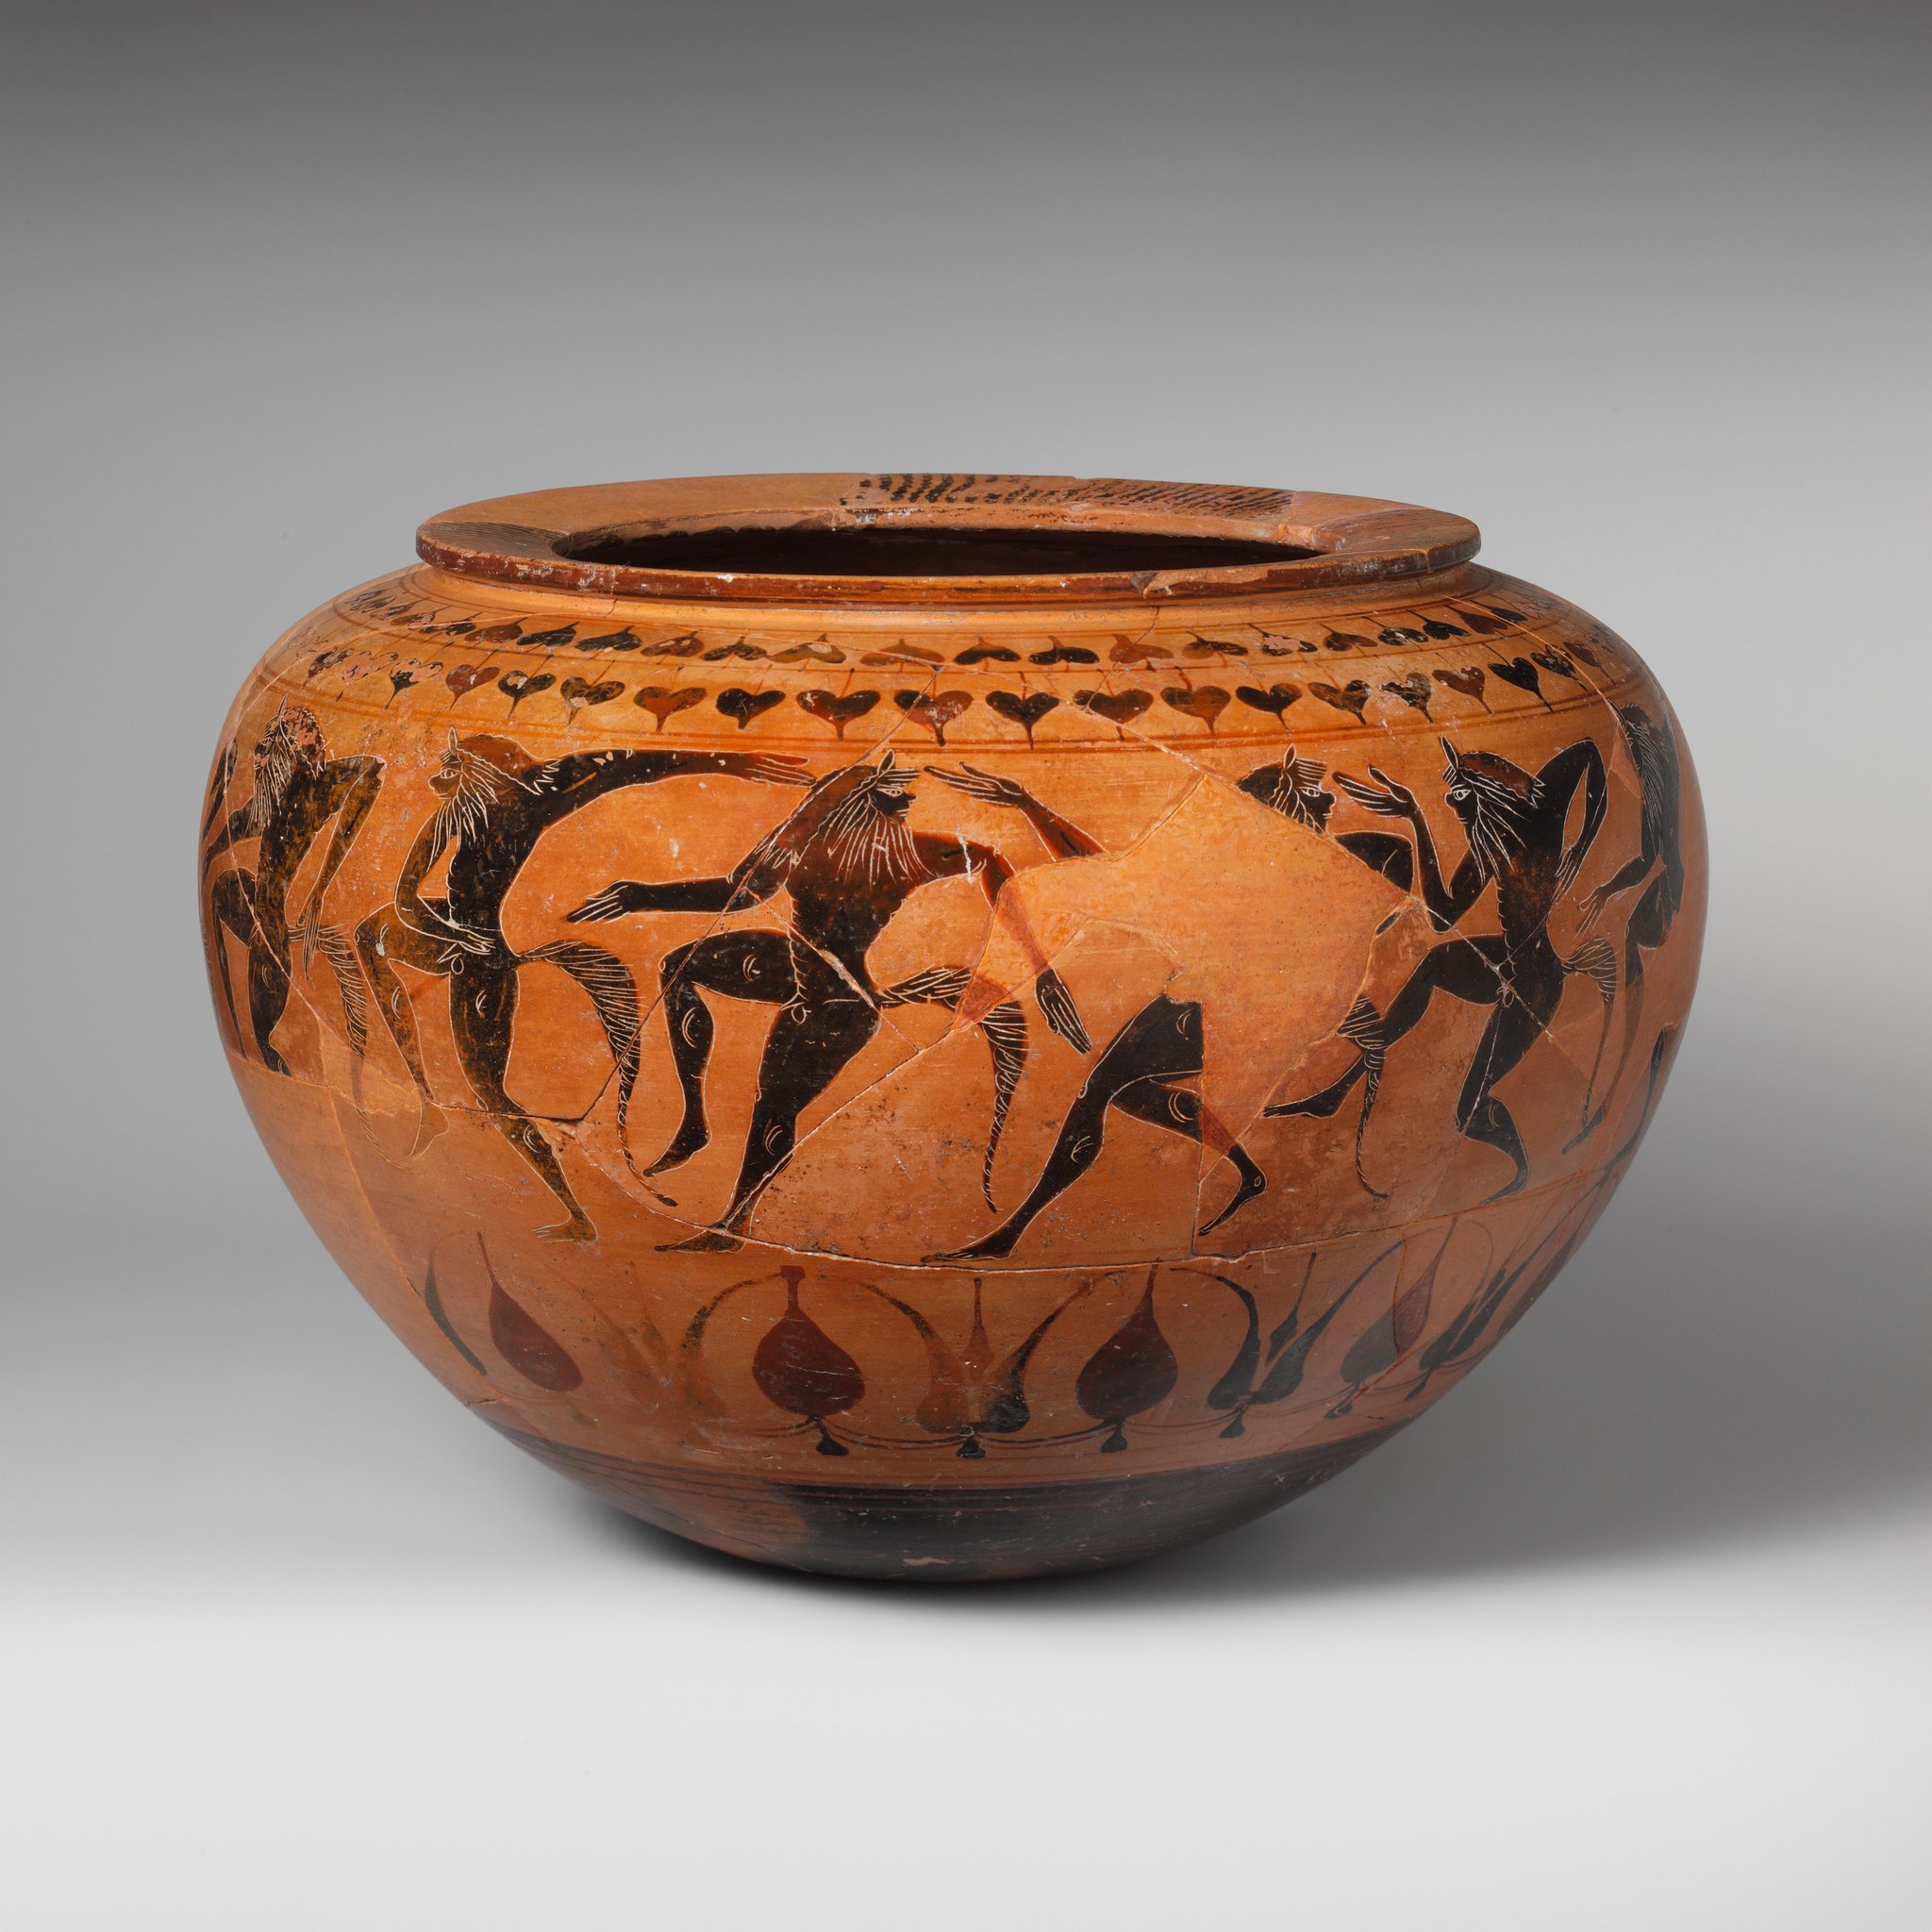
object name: dinos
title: Terracotta dinos (deep round-bottomed bowl)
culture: etruscan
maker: group of the campana dinoi, ribbon painter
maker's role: artist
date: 534-501 BCE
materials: terracotta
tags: dancing,satyrs